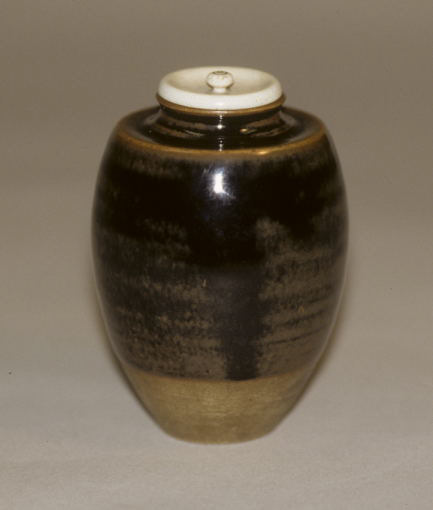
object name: tea jar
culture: japanese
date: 1701-1800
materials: clay, glaze